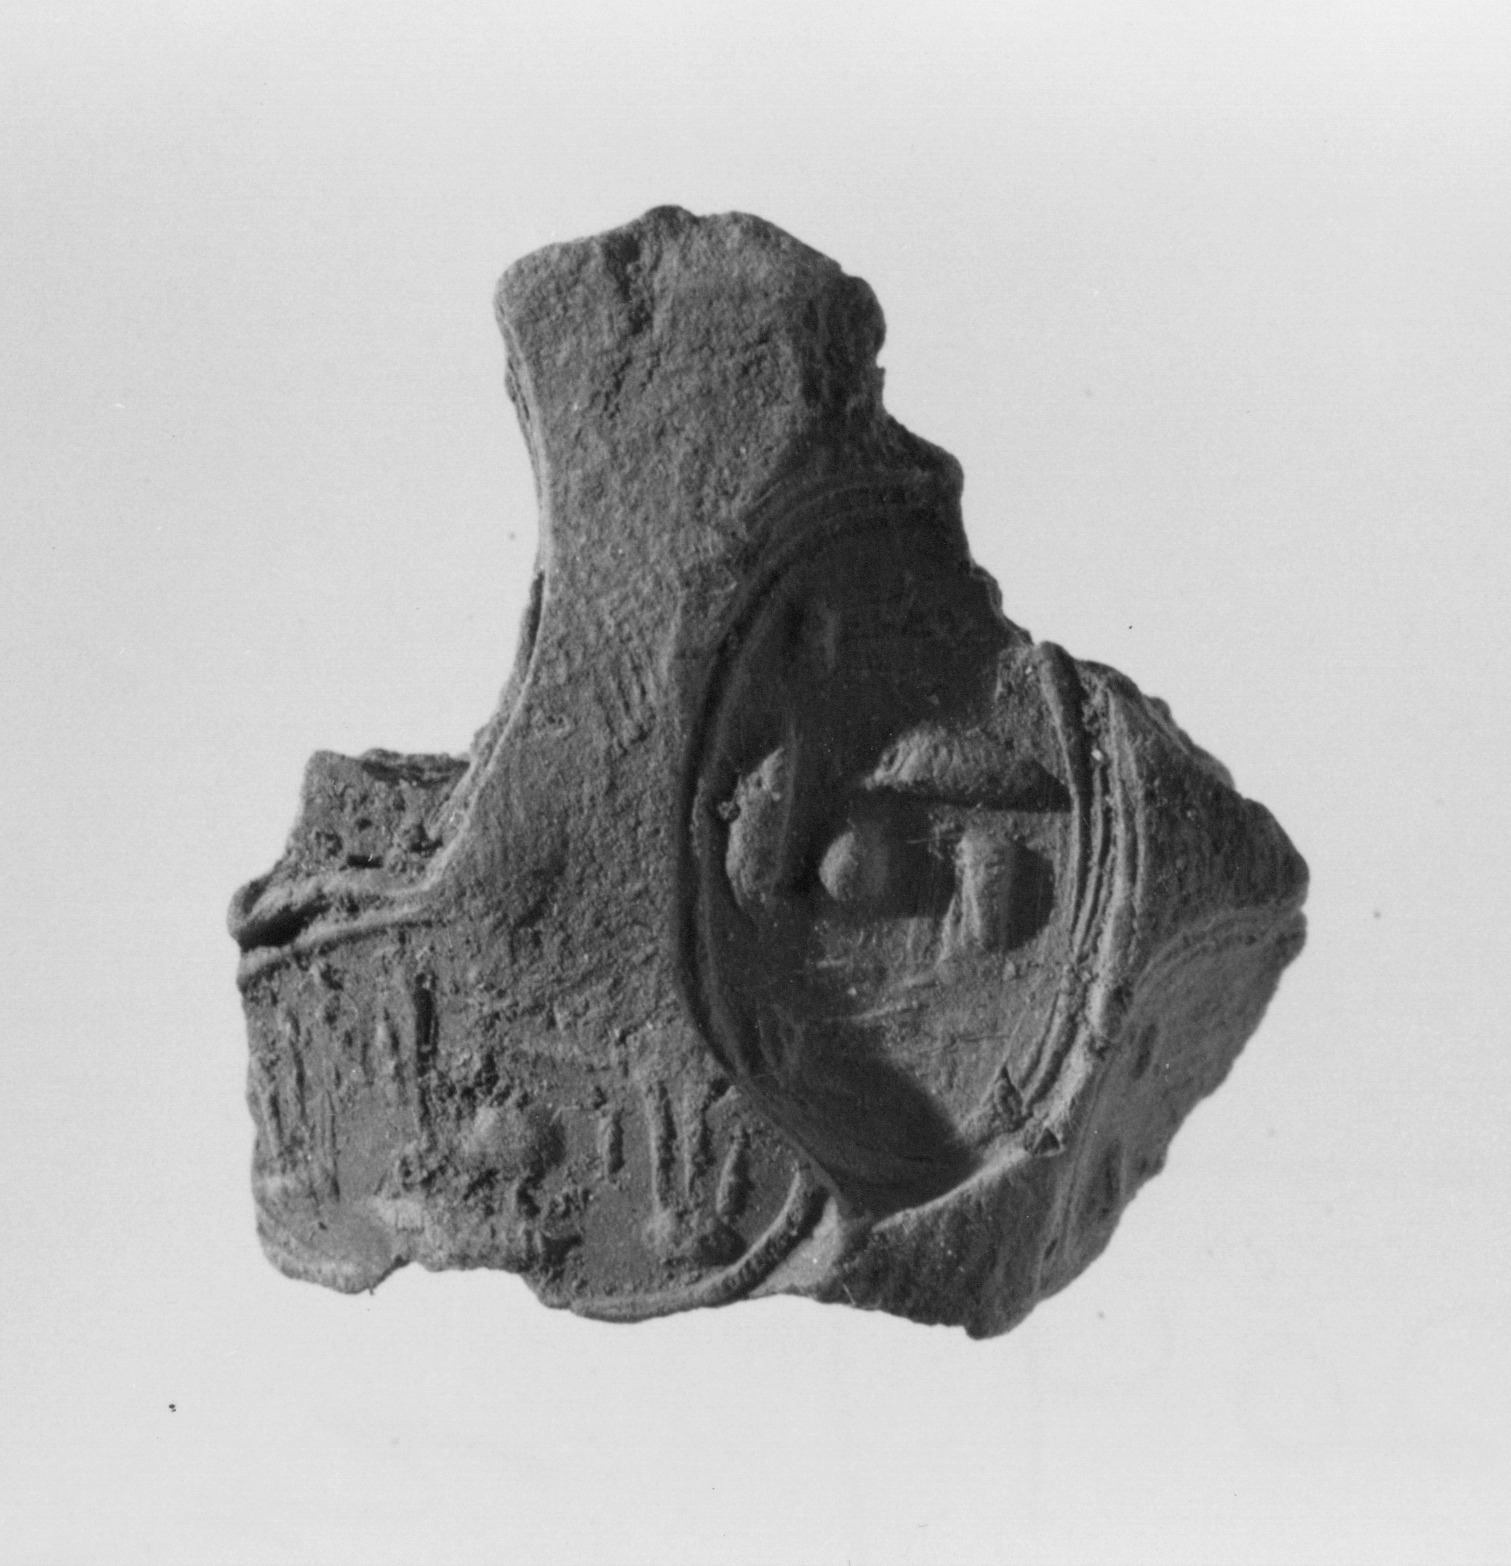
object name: sealing, upper egypt, lower egypt, amun re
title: Document Sealing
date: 1390-1352 BCE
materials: mud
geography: egypt